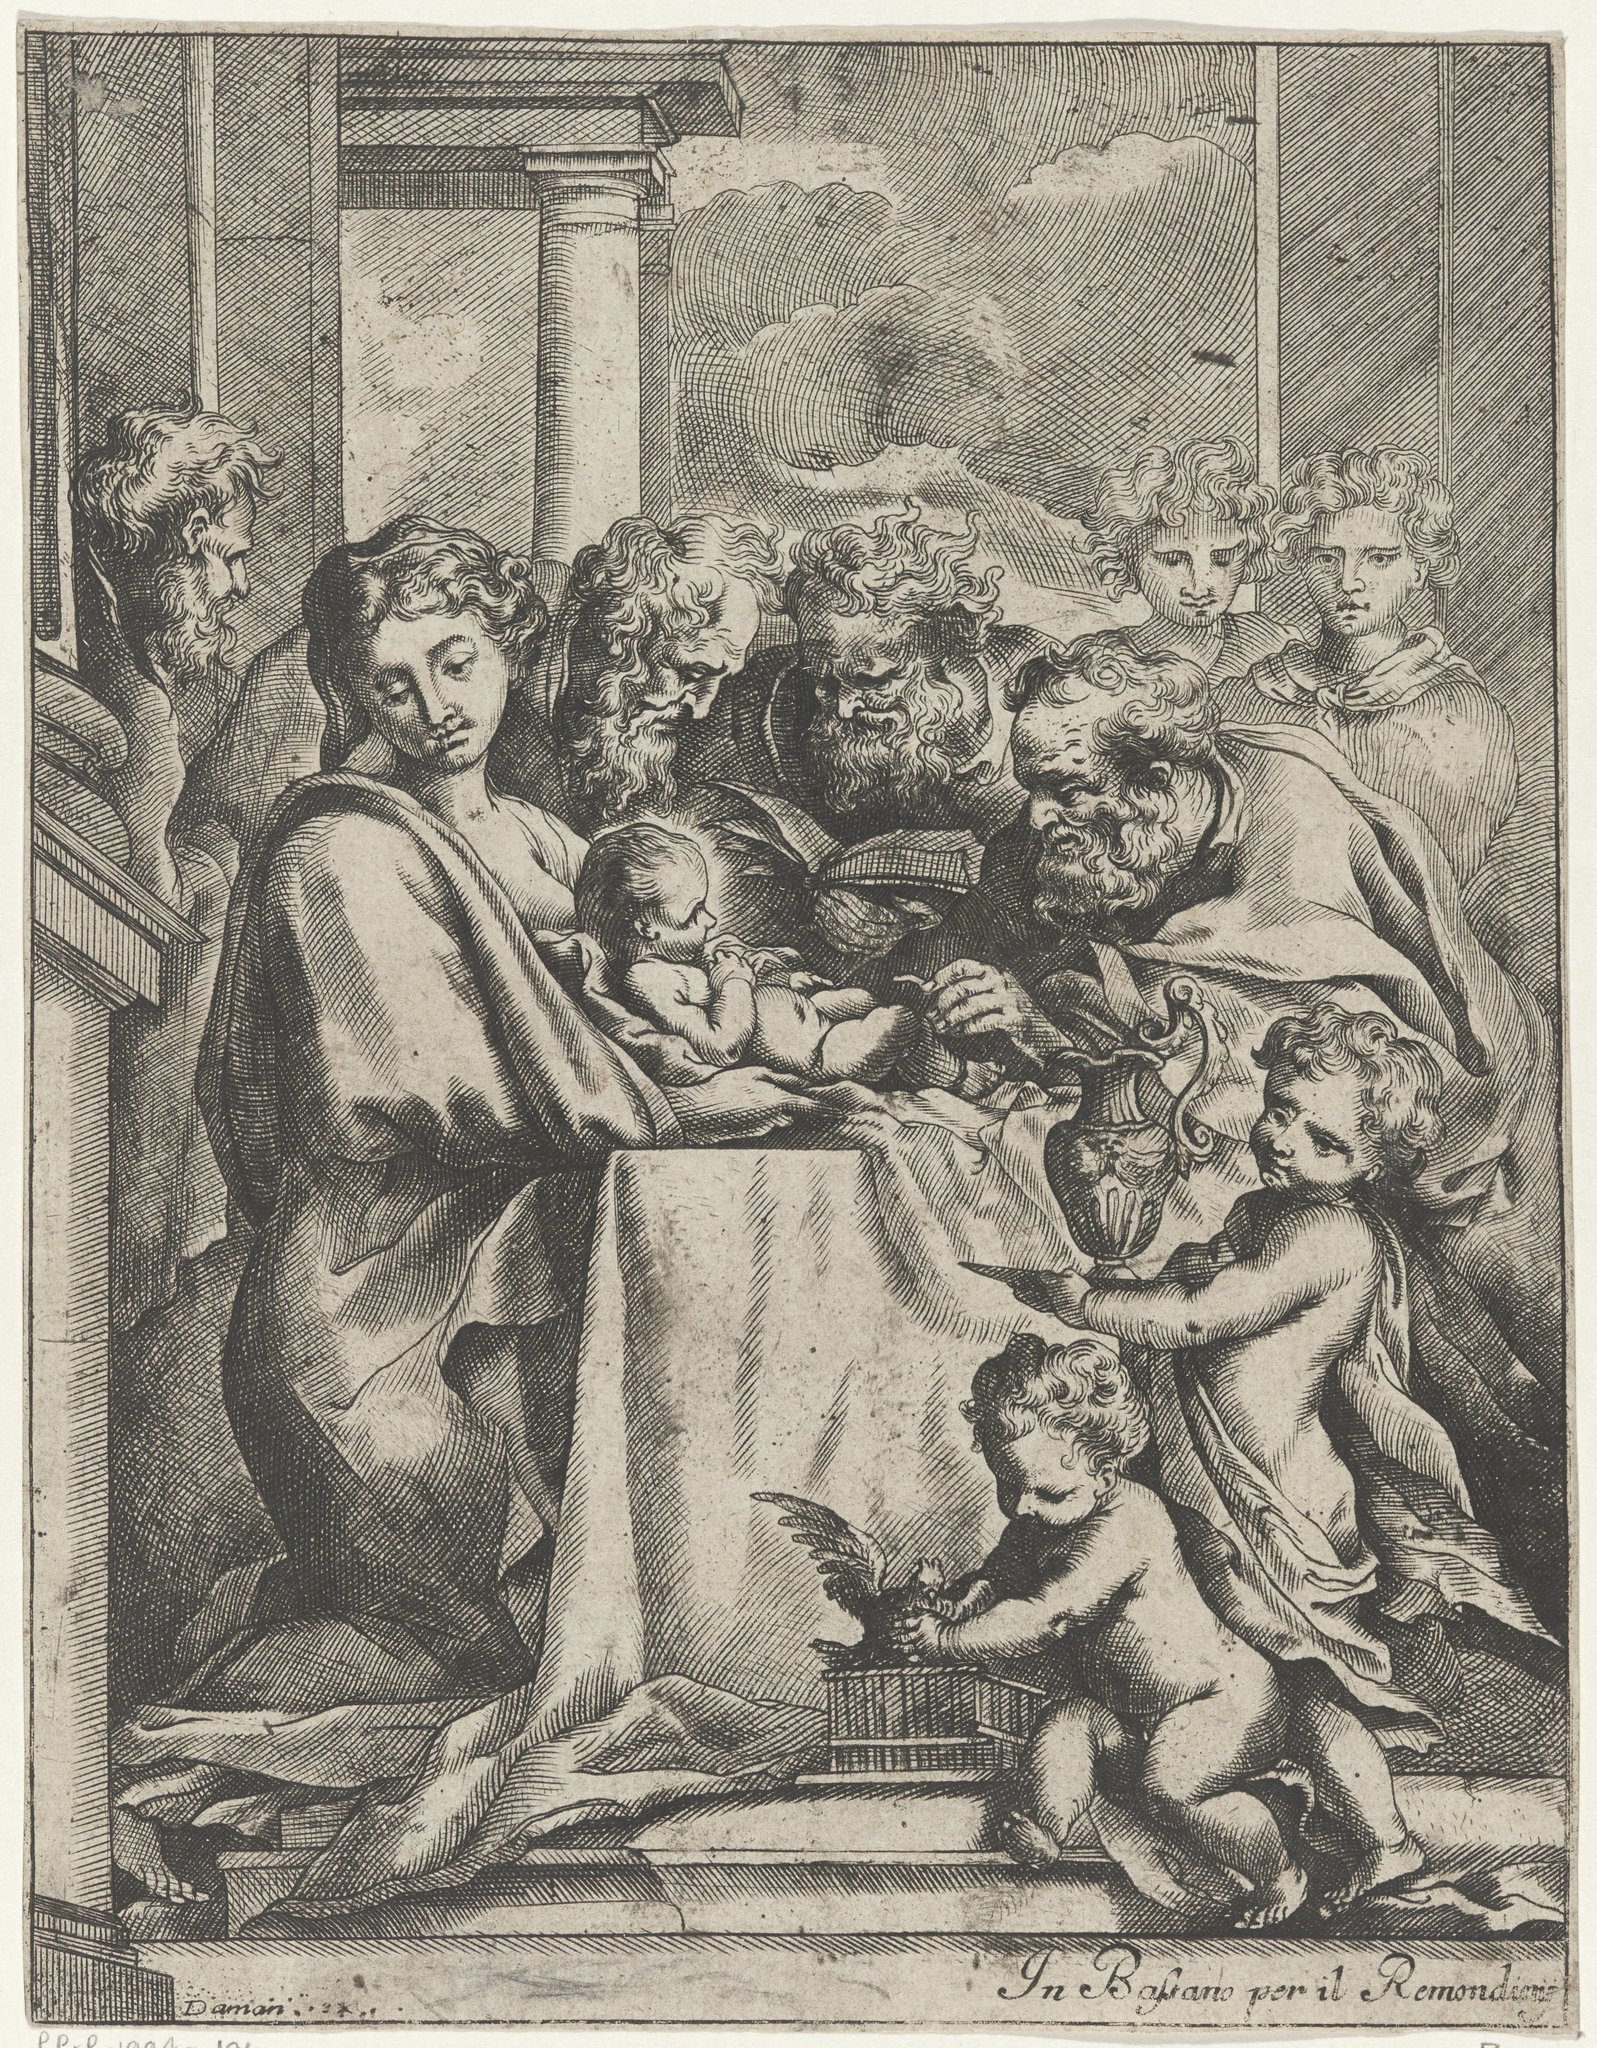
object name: print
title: Besnijdenis van Christus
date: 1640-1657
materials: paper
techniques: engraving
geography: italy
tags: circumcision of the christ-child by the priest in the temple (luke 2:21)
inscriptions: collector's mark: Lugt 2228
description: Maria zit geknield bij een tafel waarop het Christuskind wordt besneden door de hogepriester. Achter de hogepriester een tweede priester die een boek leest, Jozef en twee jongemannen. Op de voorgrond twee putti met een kooi met duif en een kan.